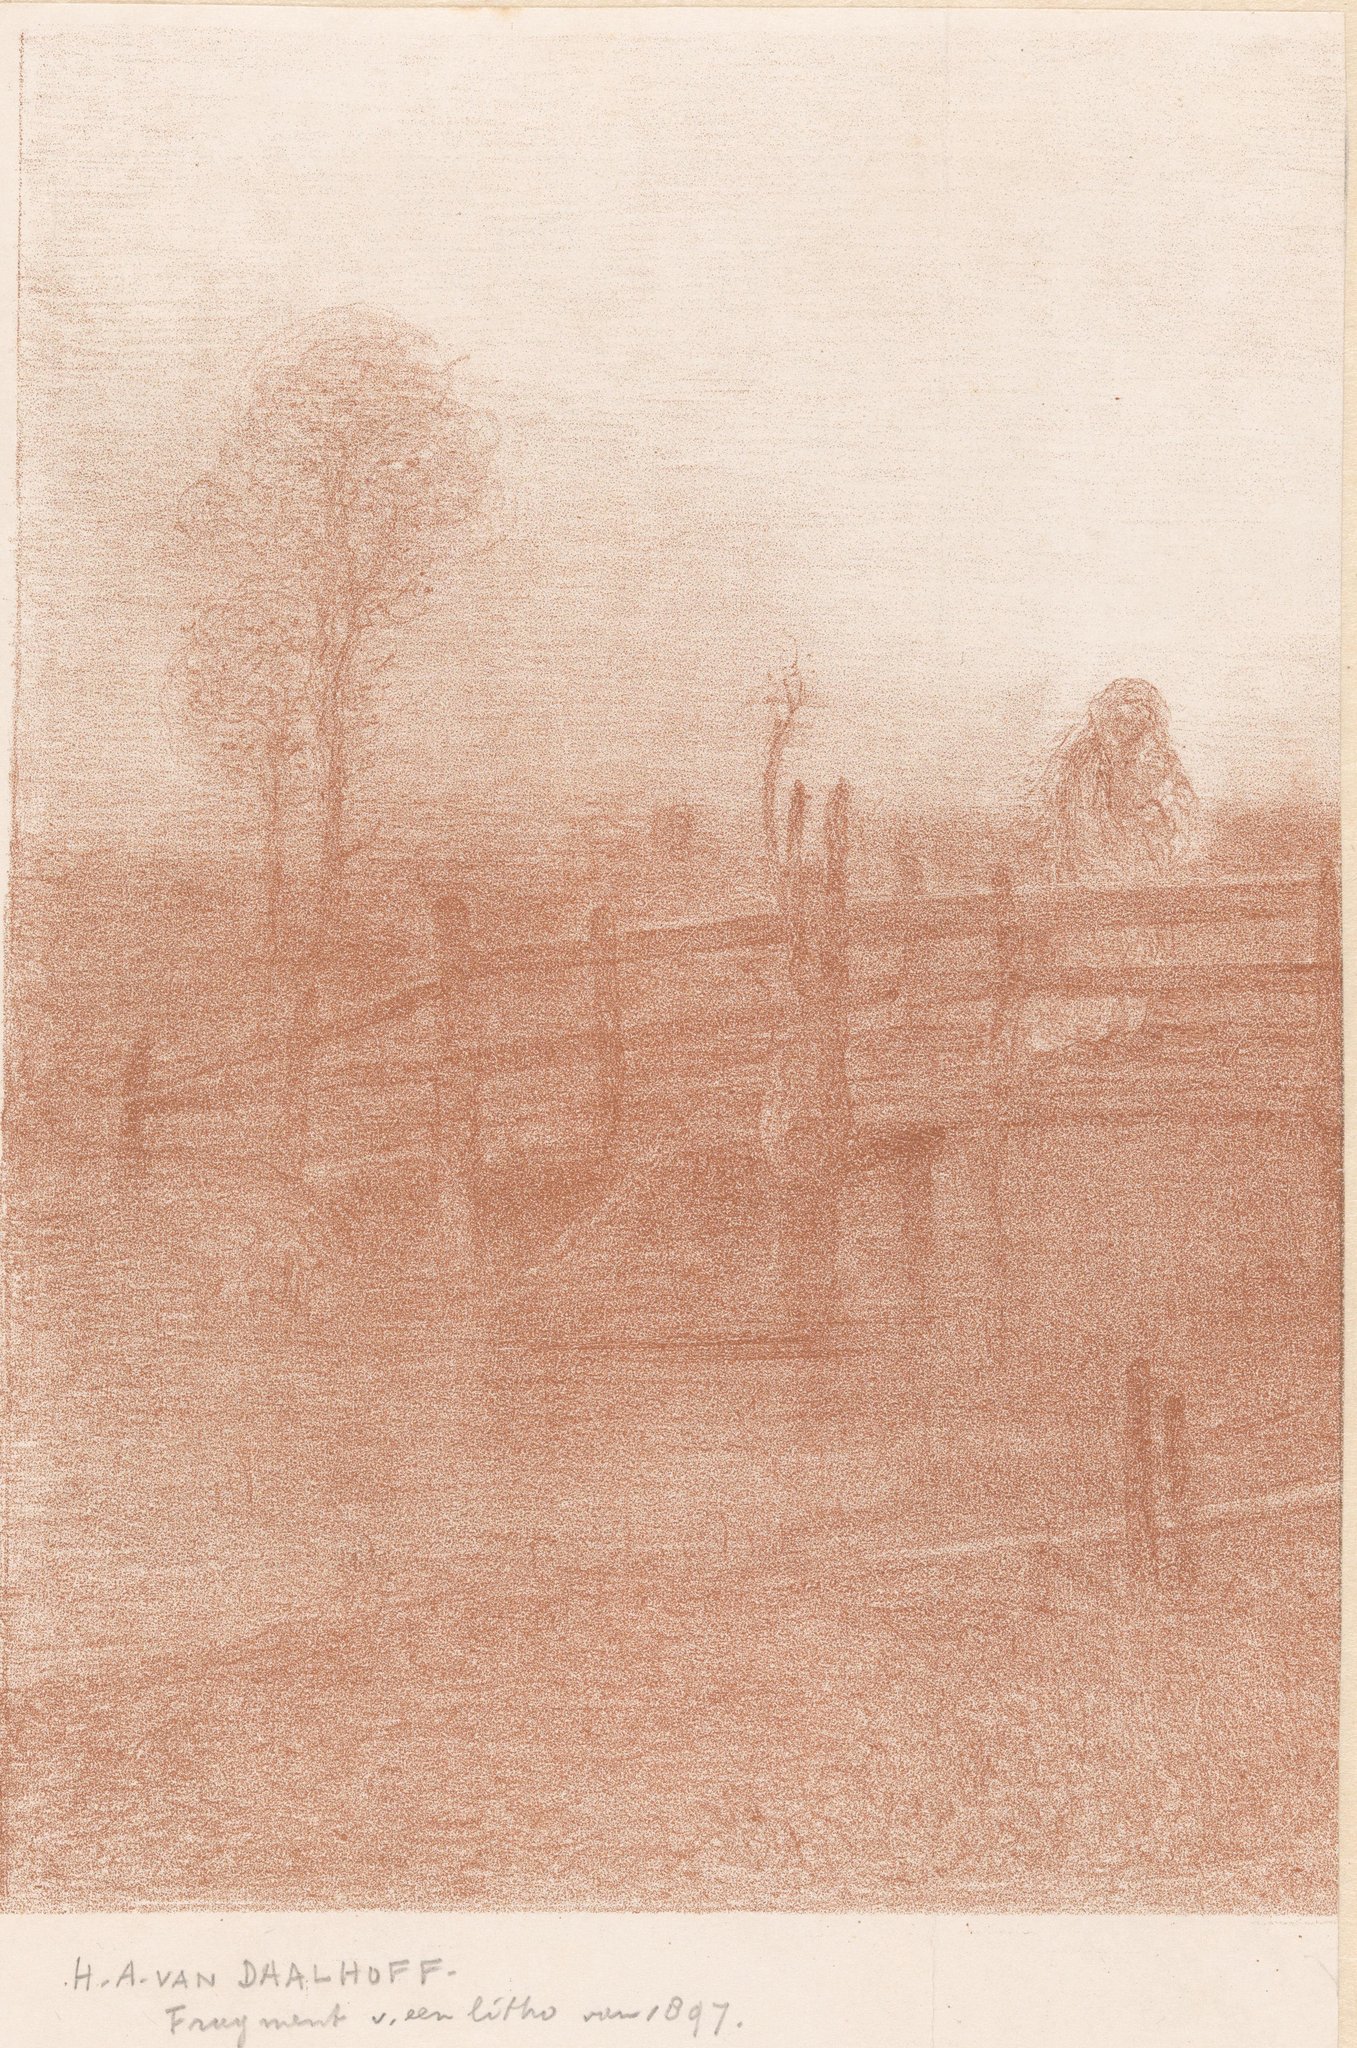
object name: print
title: Vrouw op een houten brug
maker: herman antonius van daalhoff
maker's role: draughtsman, print maker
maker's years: 1867-1953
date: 1897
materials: paper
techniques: lithograph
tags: walking - aa - female human figure, bridge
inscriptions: collector's mark: Lugt 2228